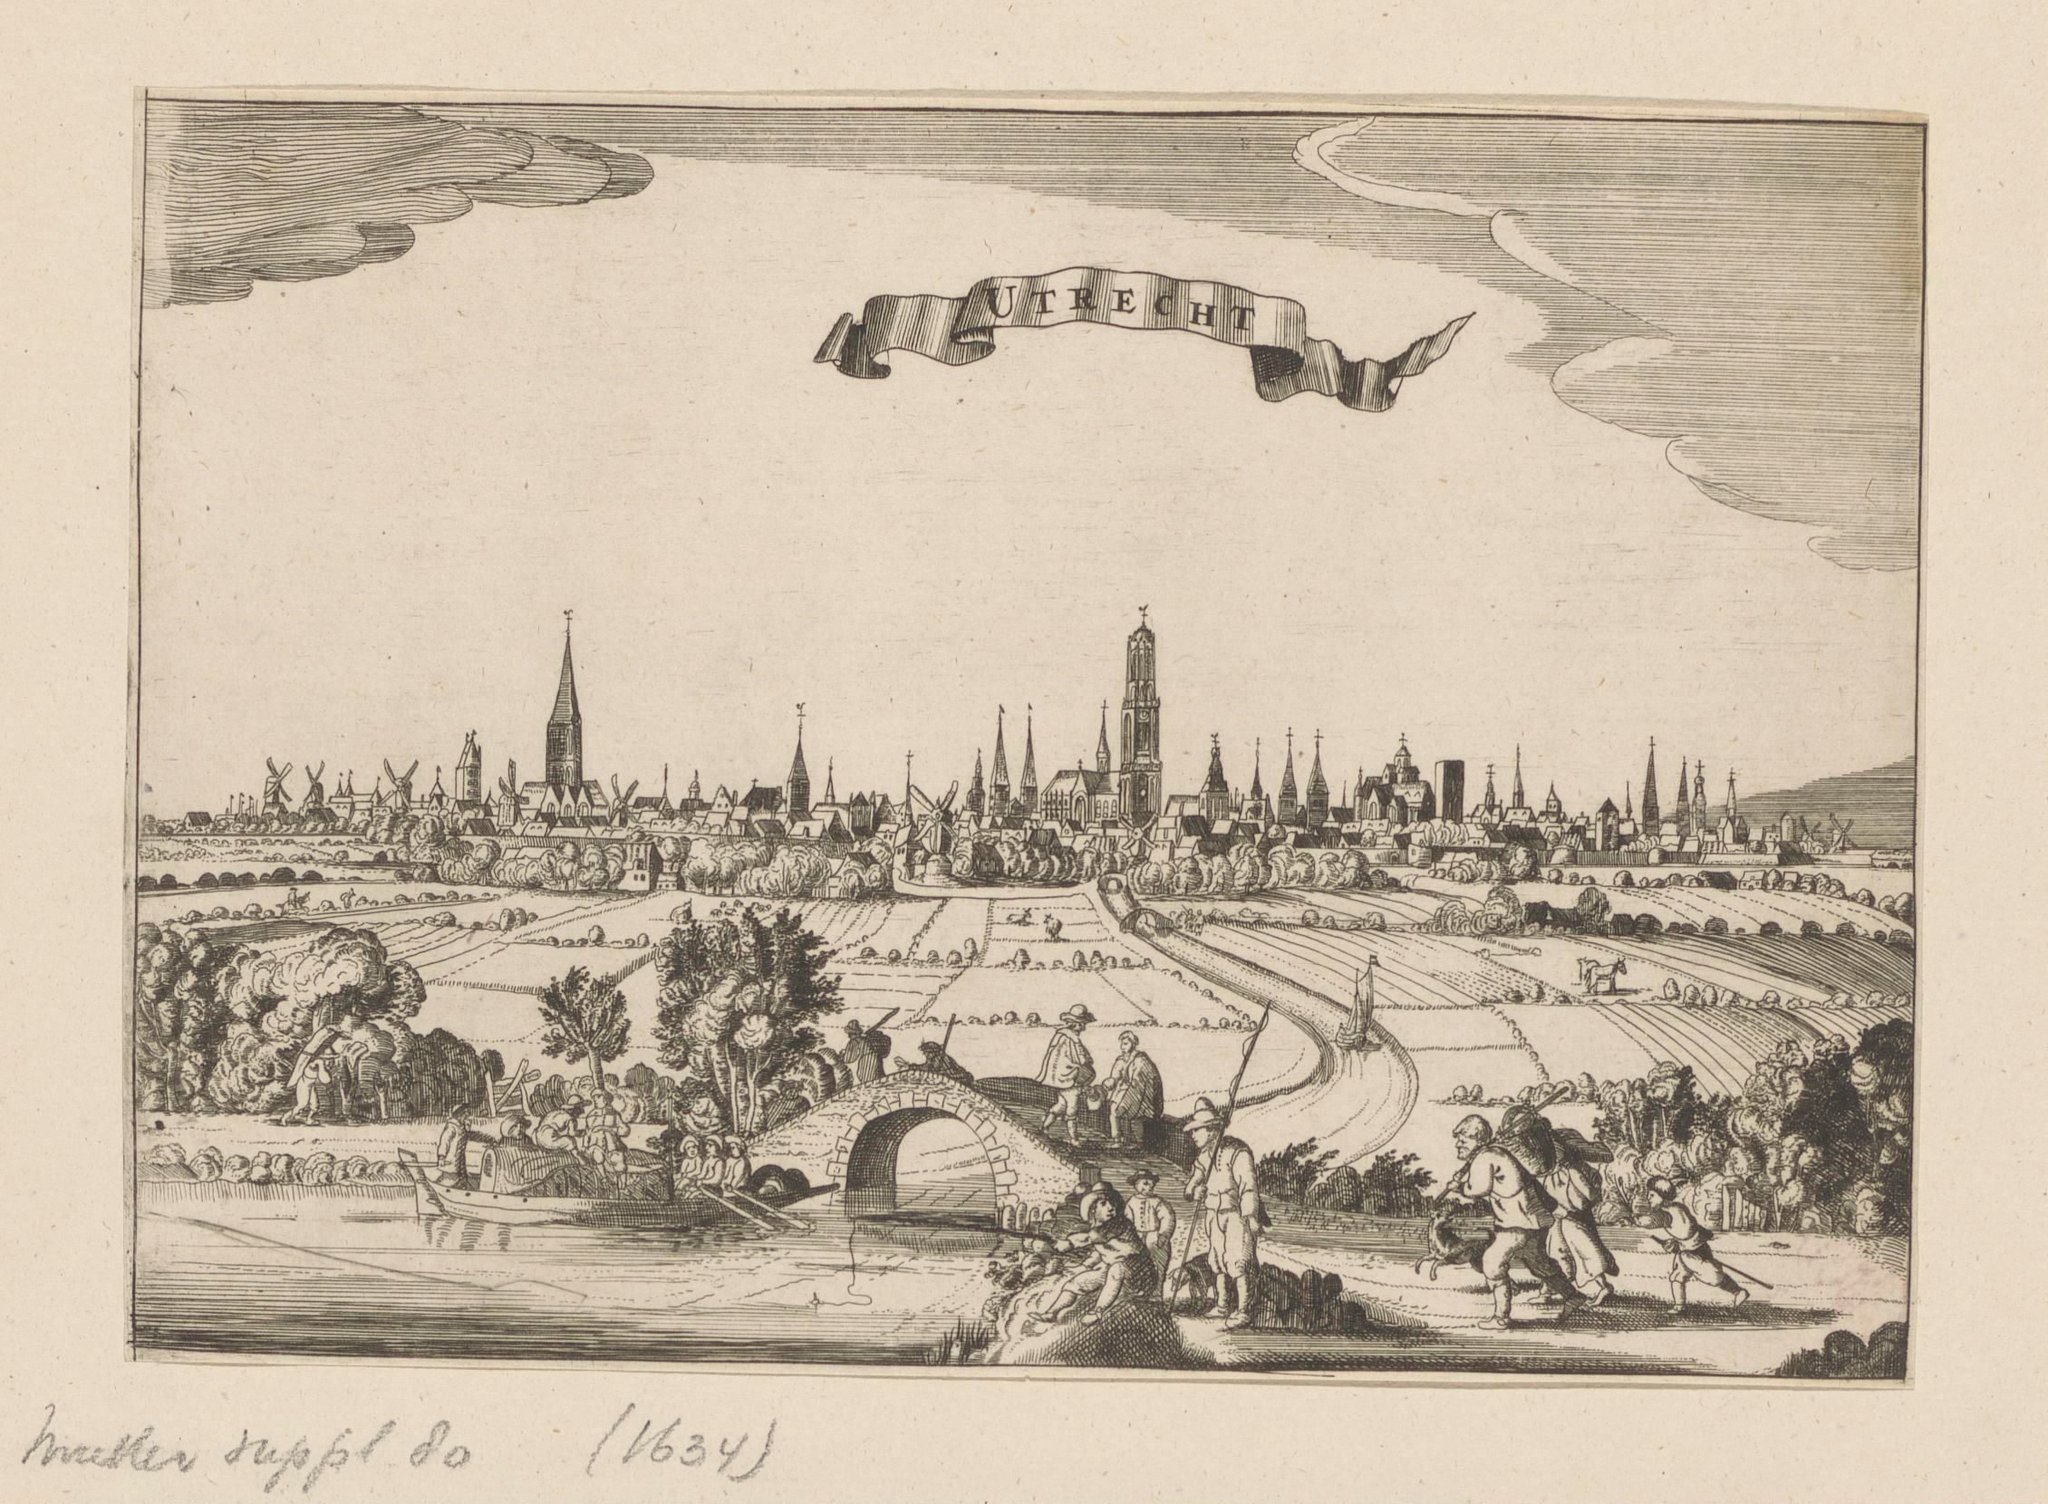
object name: print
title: Utrecht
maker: Anonymous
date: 1600-1699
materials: paper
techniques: etching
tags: city-view in general; 'veduta', utrecht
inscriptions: collector's mark: Lugt 195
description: Op de voorgrond een brug, een boot, vissers, landlopers en nog een aantal figuren. Op de achtergrond de stad.